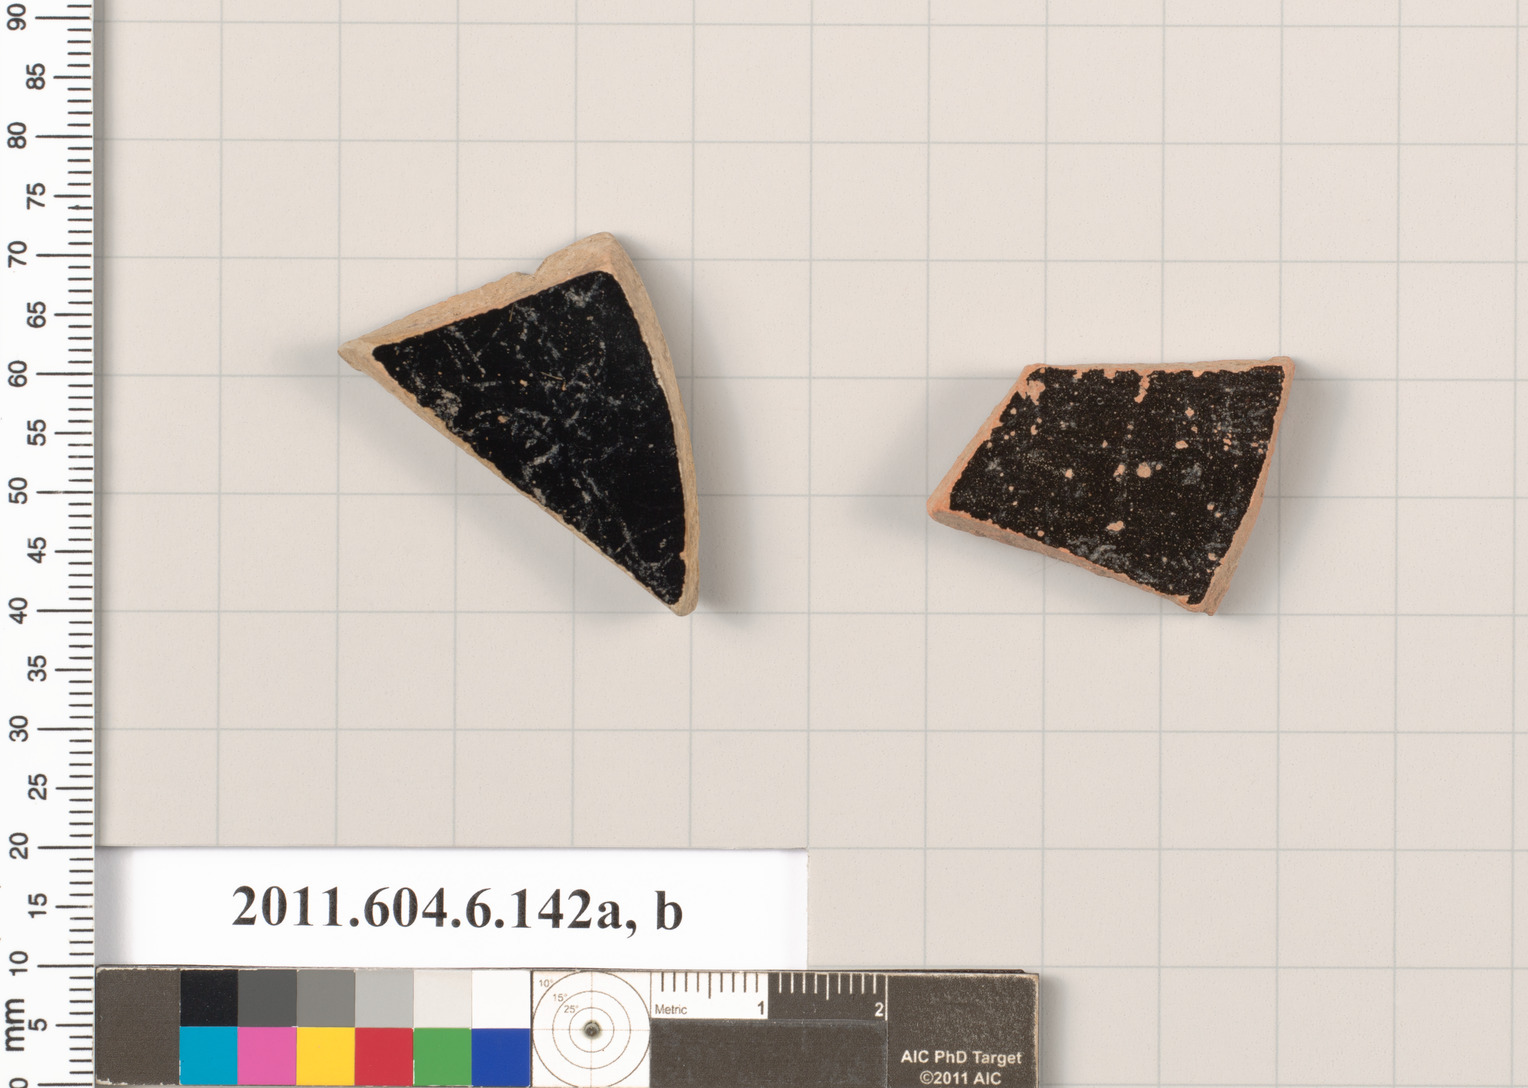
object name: undetermined open shape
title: Terracotta fragments of open shapes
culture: greek, attic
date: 600-401 BCE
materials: terracotta